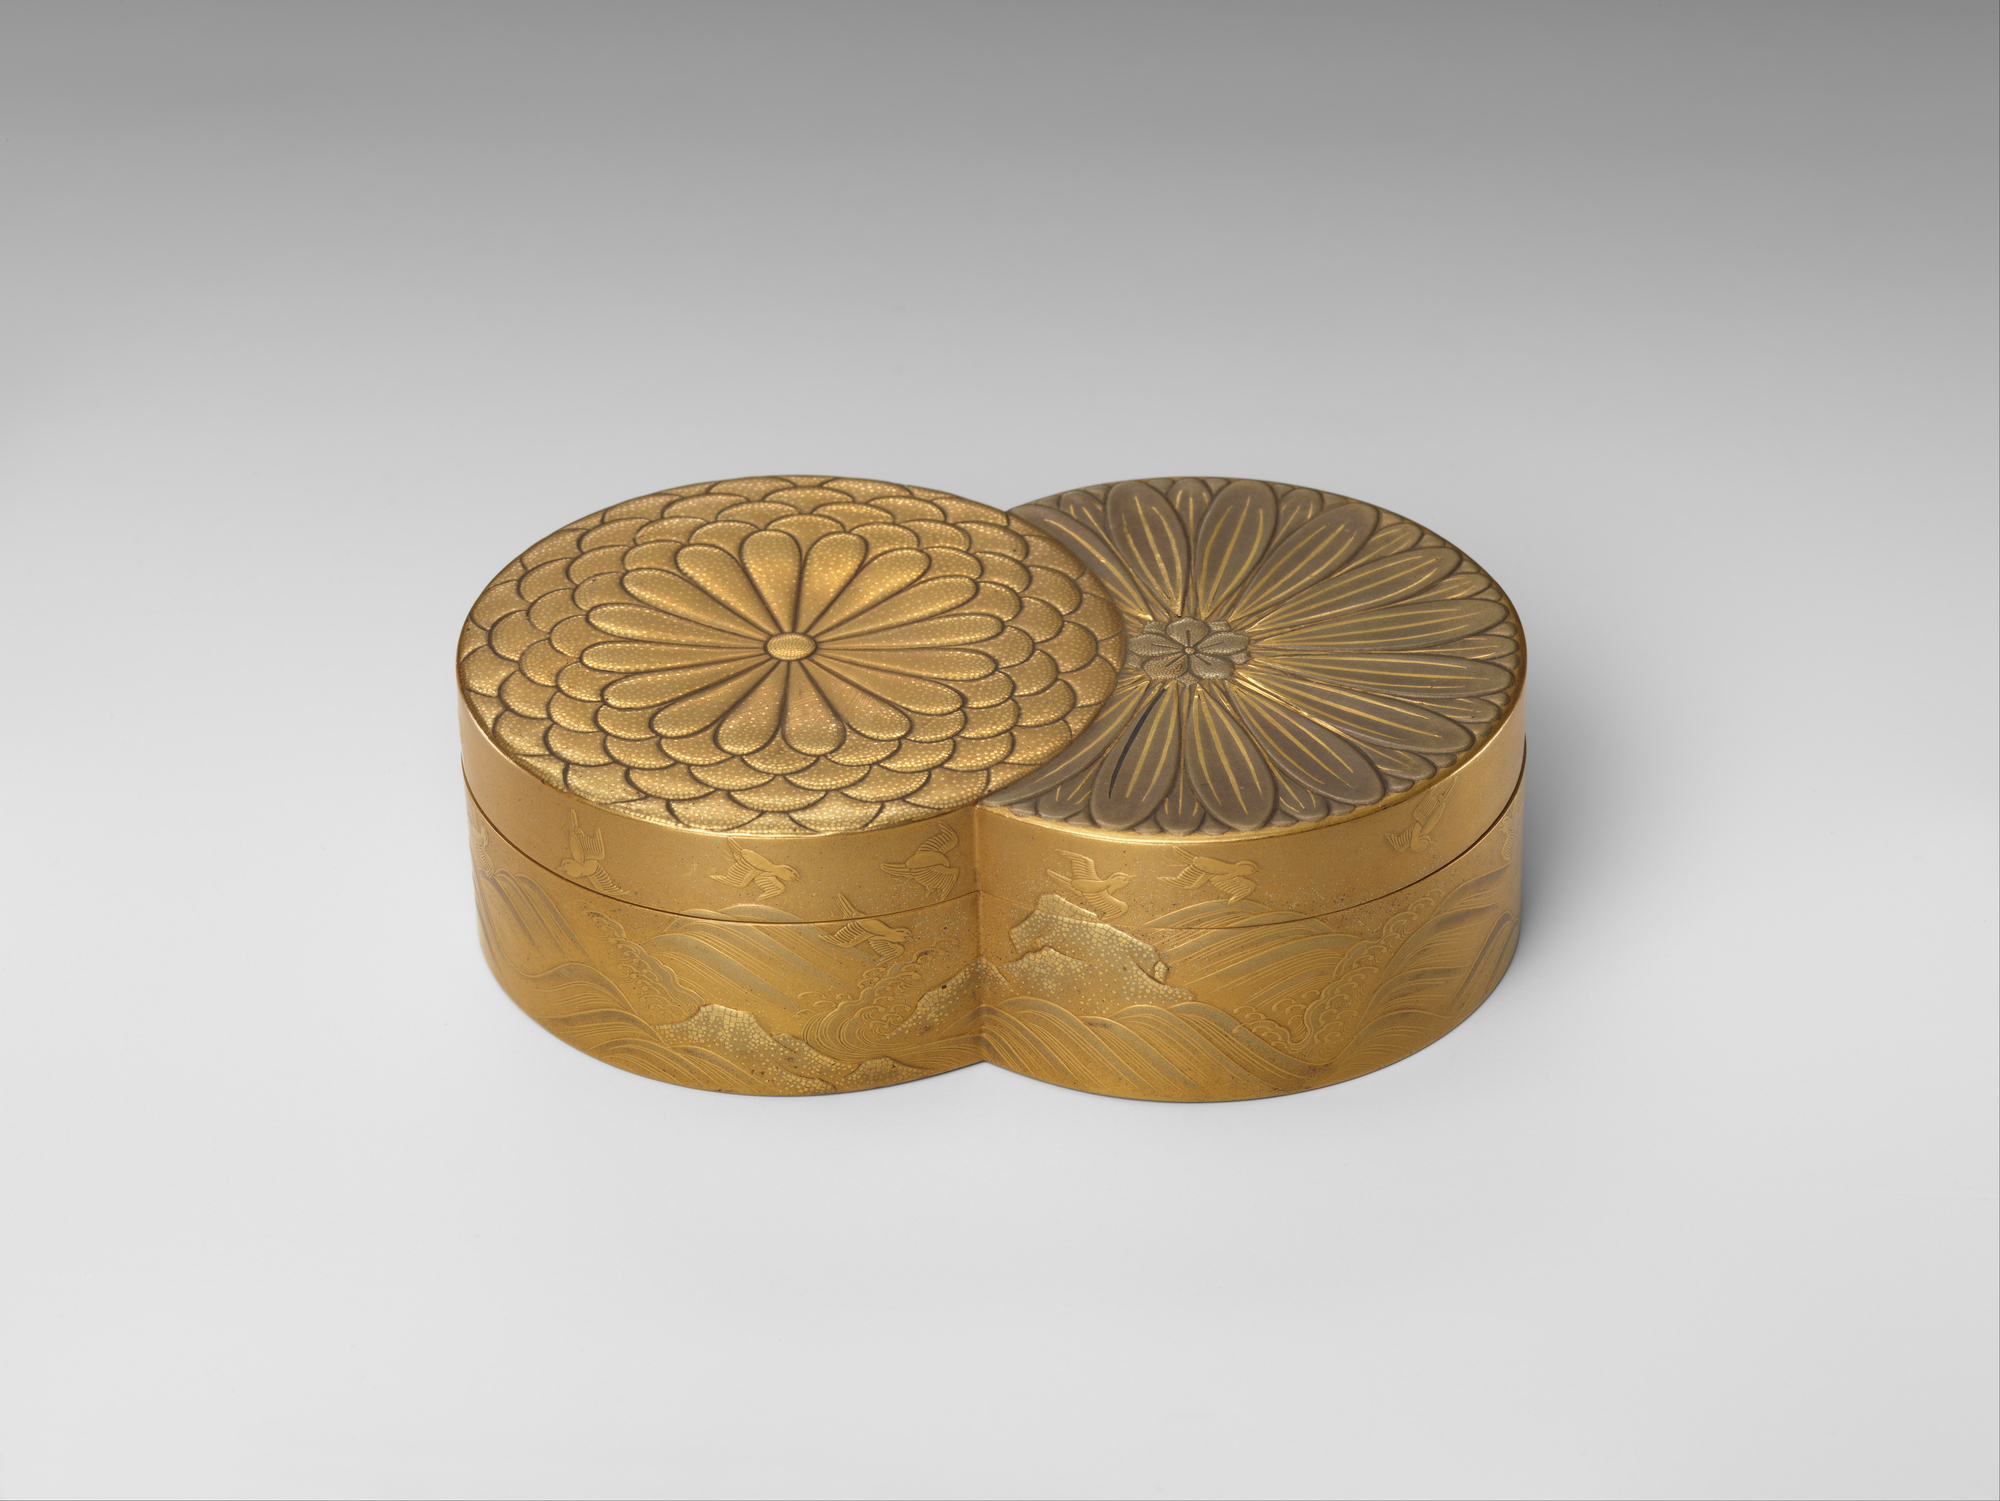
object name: incense box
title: Incense Box in Shape of Overlapped Chrysanthemums; The Chrysanthemum Youth (Inside Tray)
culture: japanese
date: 1834-1866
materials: gold, gold leaf, silver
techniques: hiramakie, maki-e